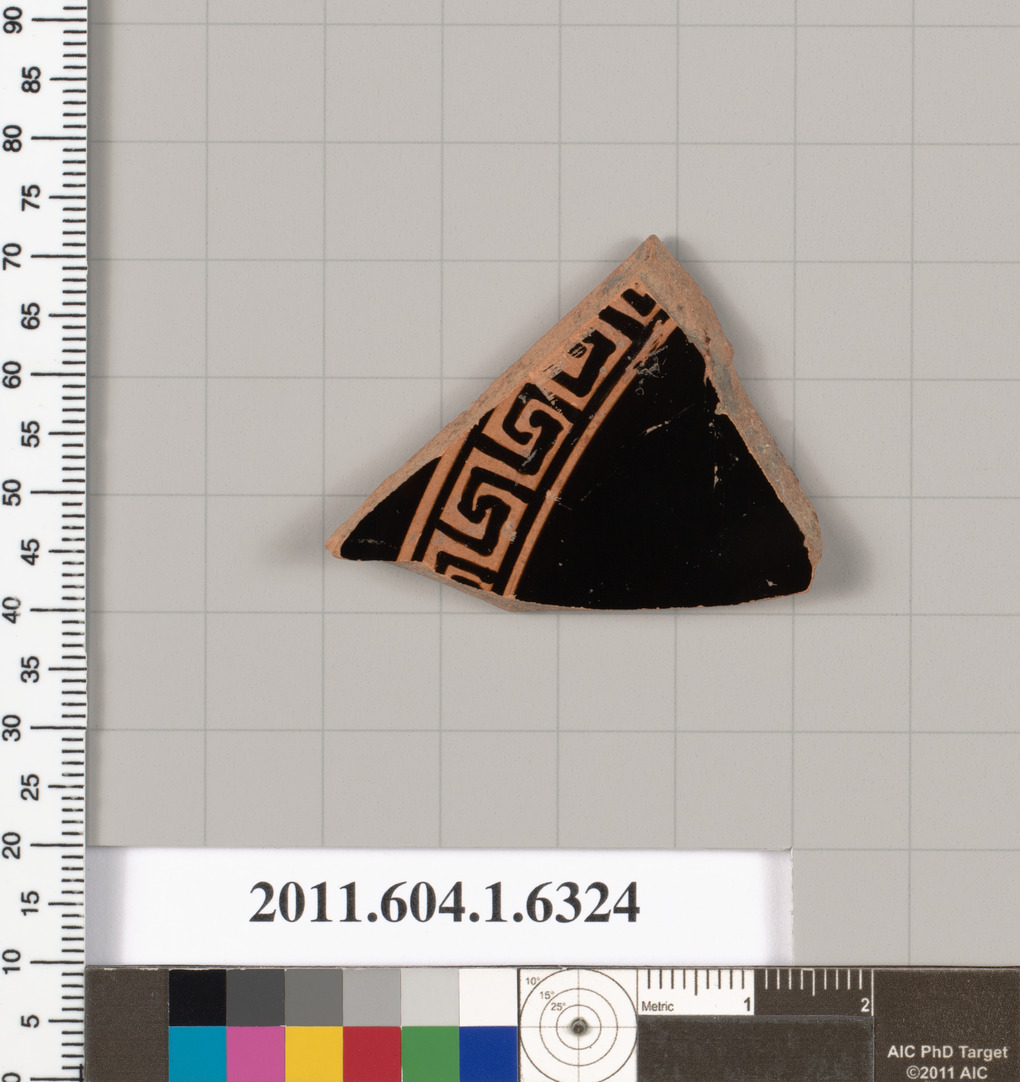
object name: kylix fragment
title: Terracotta fragment of a kylix (drinking cup)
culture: greek, attic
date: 500-480 BCE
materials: terracotta